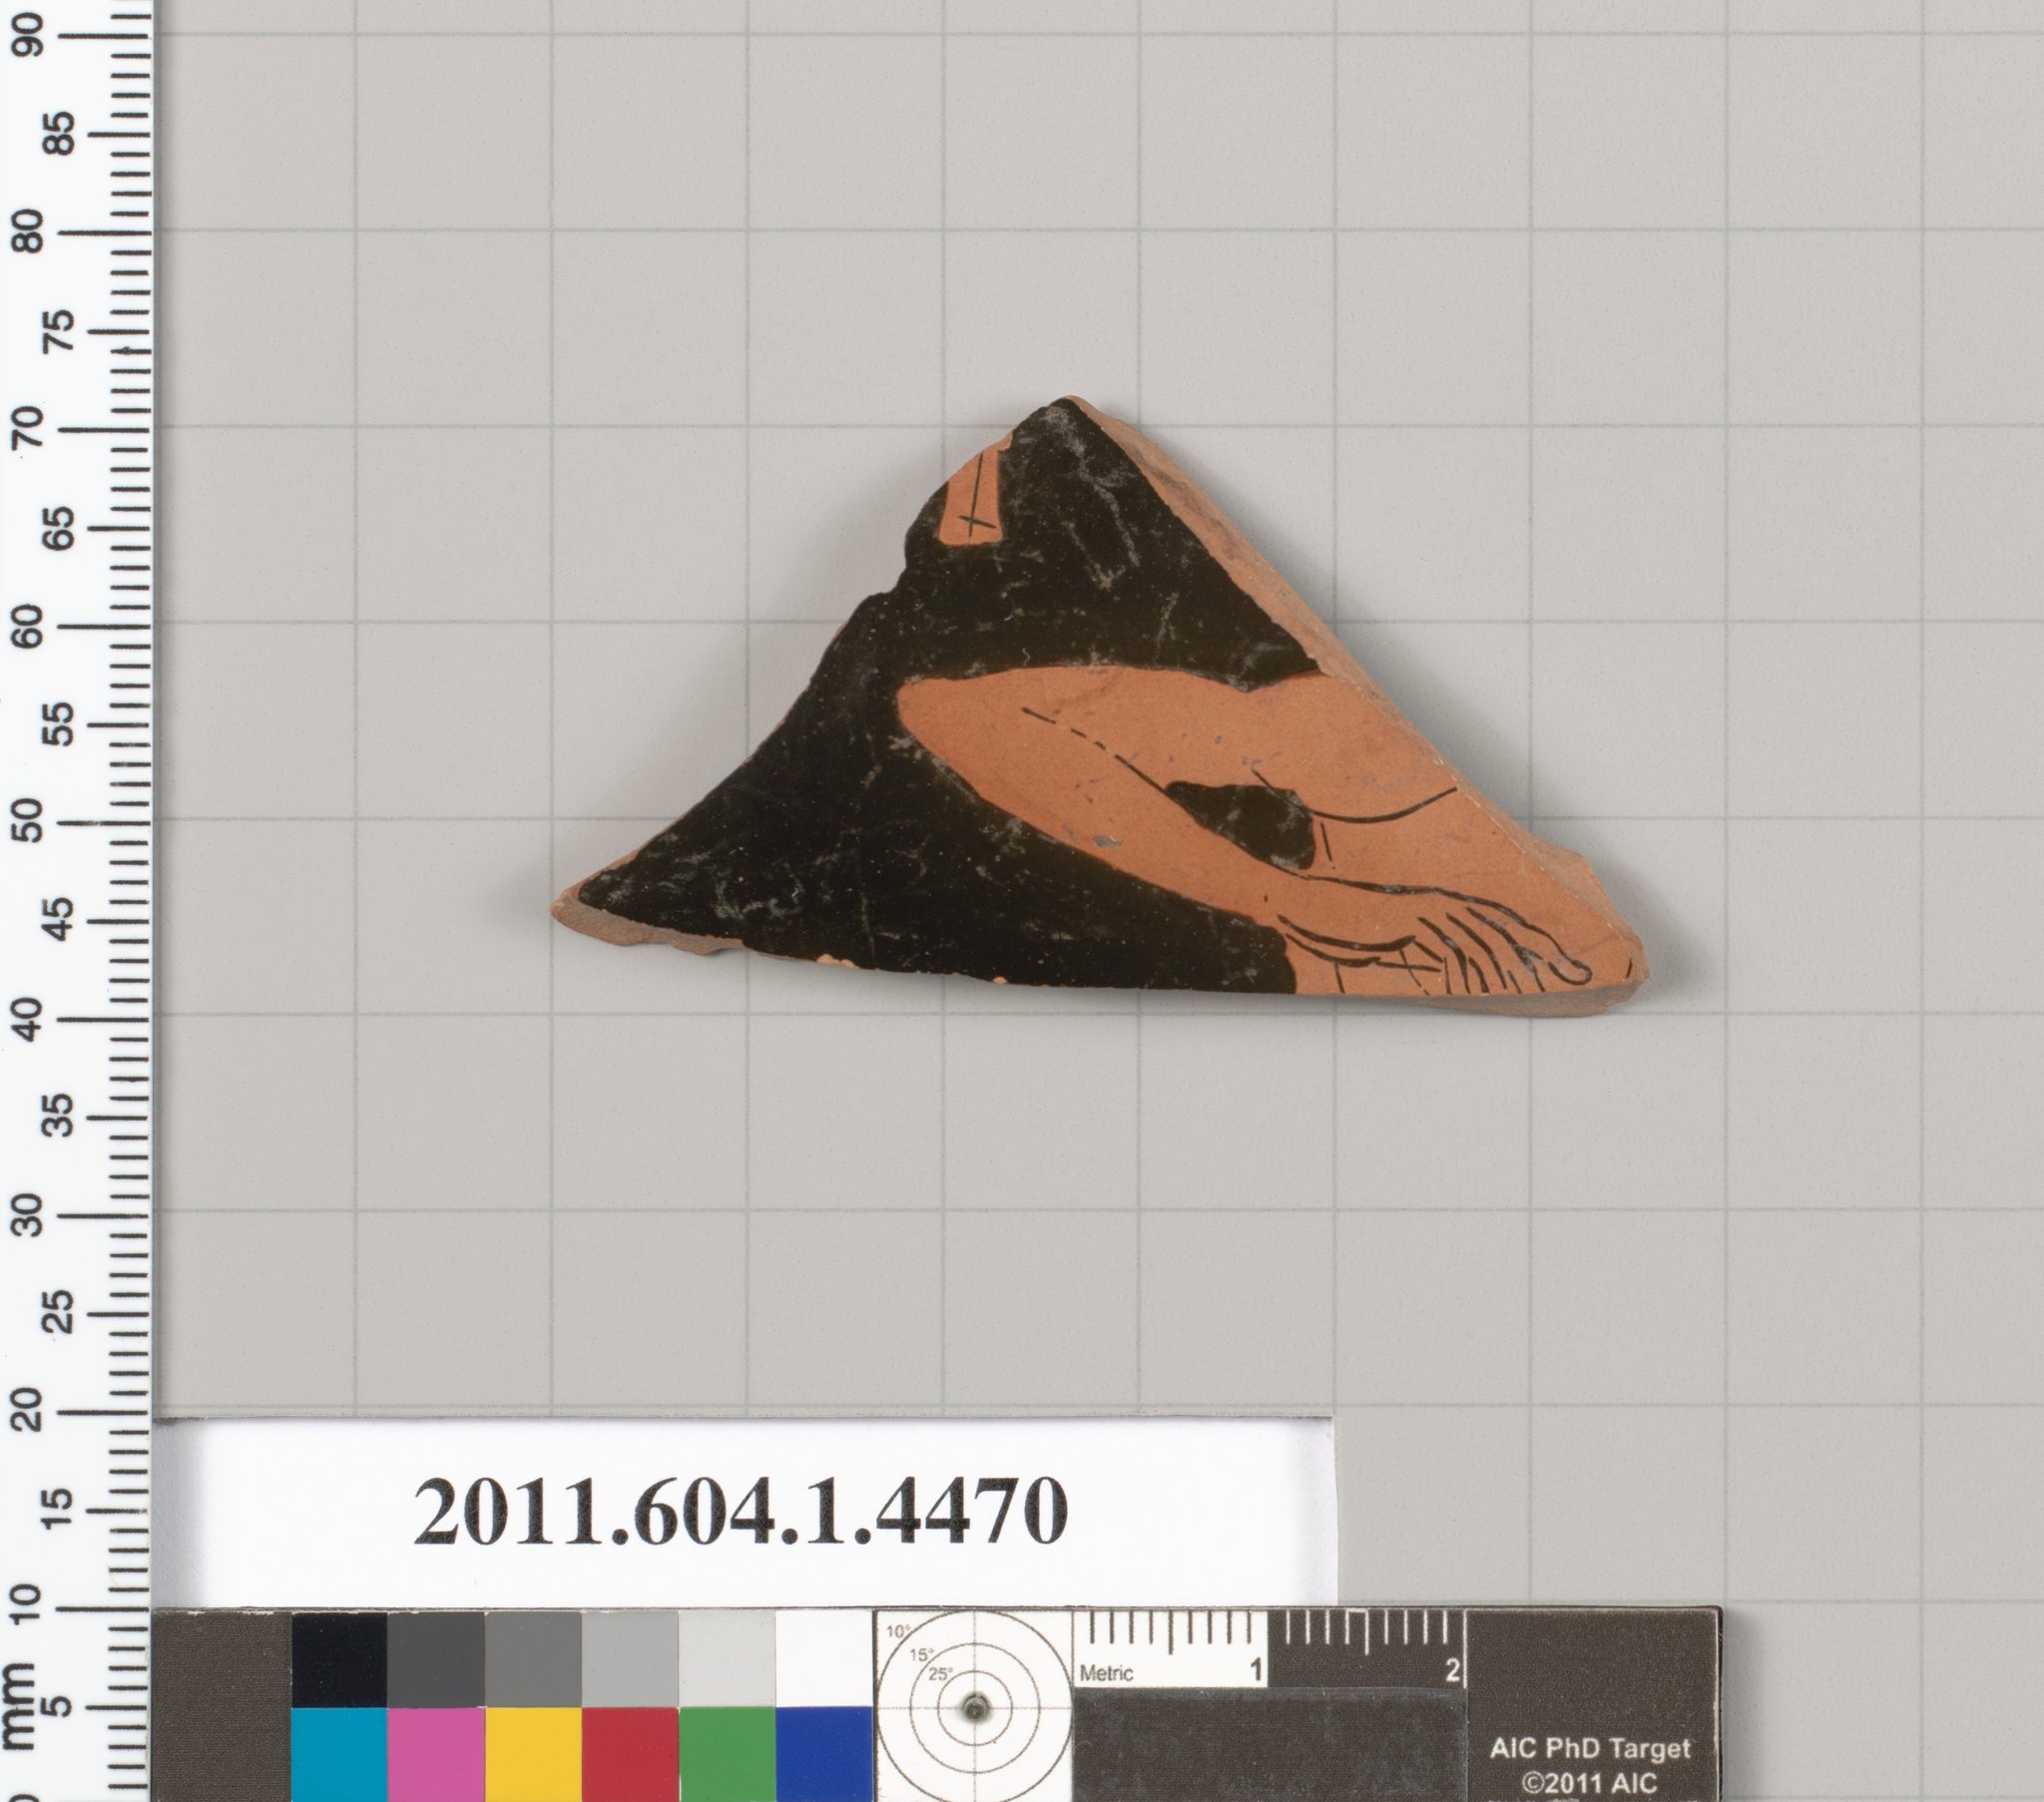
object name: kylix fragment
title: Terracotta fragment of a kylix (drinking cup)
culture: greek, attic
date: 480-470 BCE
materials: terracotta